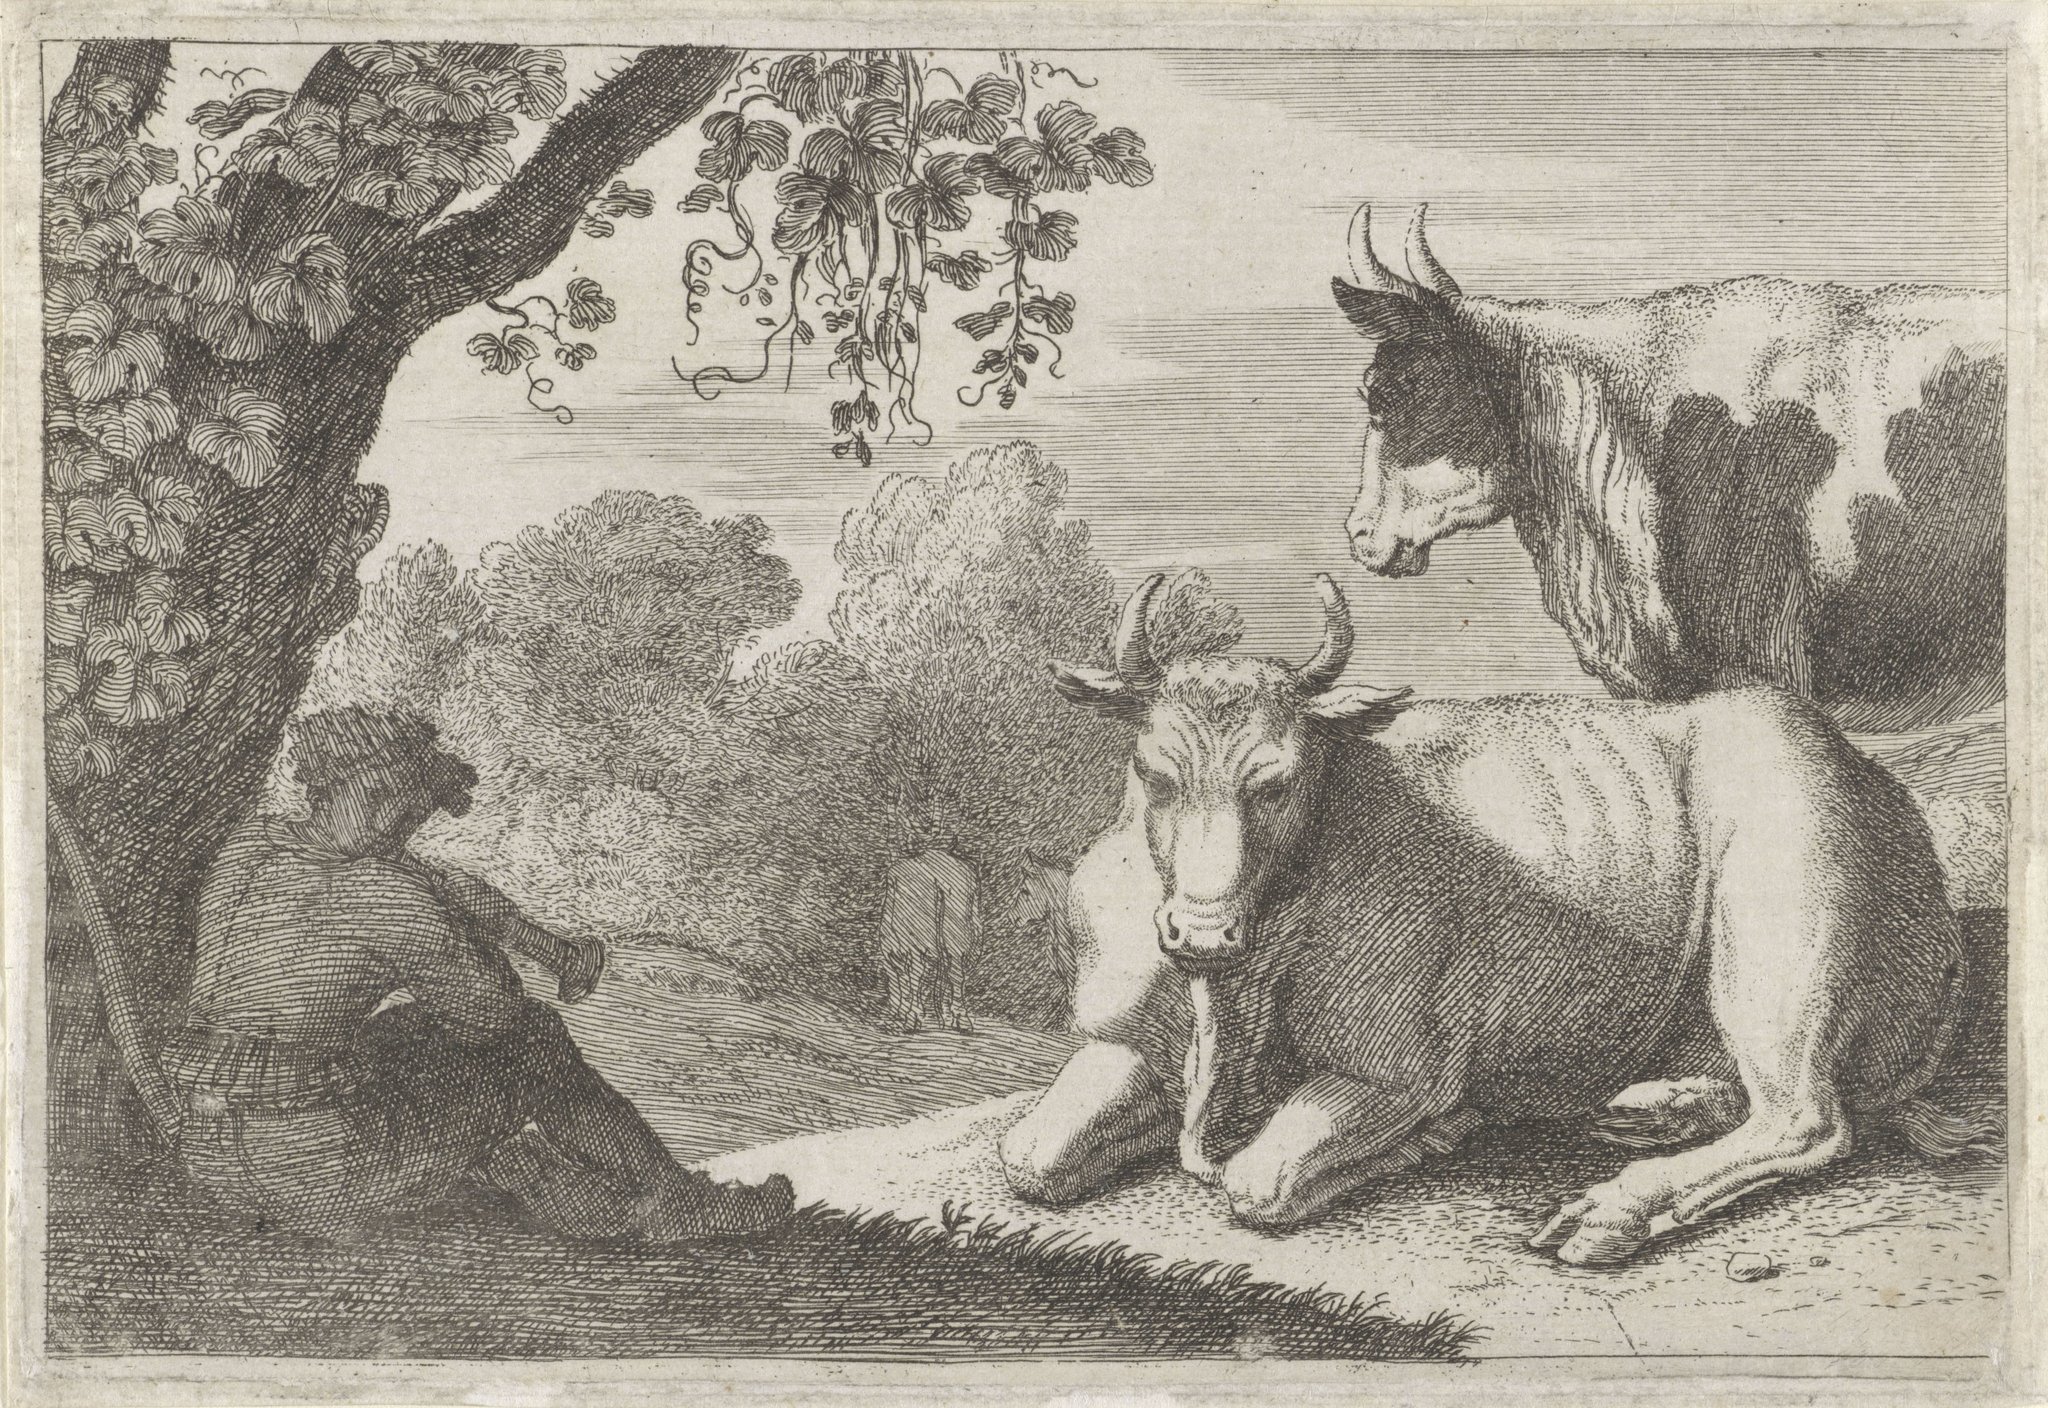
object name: print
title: Landschappen met dieren (serie A)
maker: Anonymous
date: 1636-1705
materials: paper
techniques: etching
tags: cow, landscapes, herding, herdsman, herdswoman, shepherd, shepherdess, cowherd, etc., flute, aulos, tibia - cc - out of doors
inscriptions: collector's mark: Lugt 2228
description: Onder een boom zit een herder met een fluit bij twee koeien.